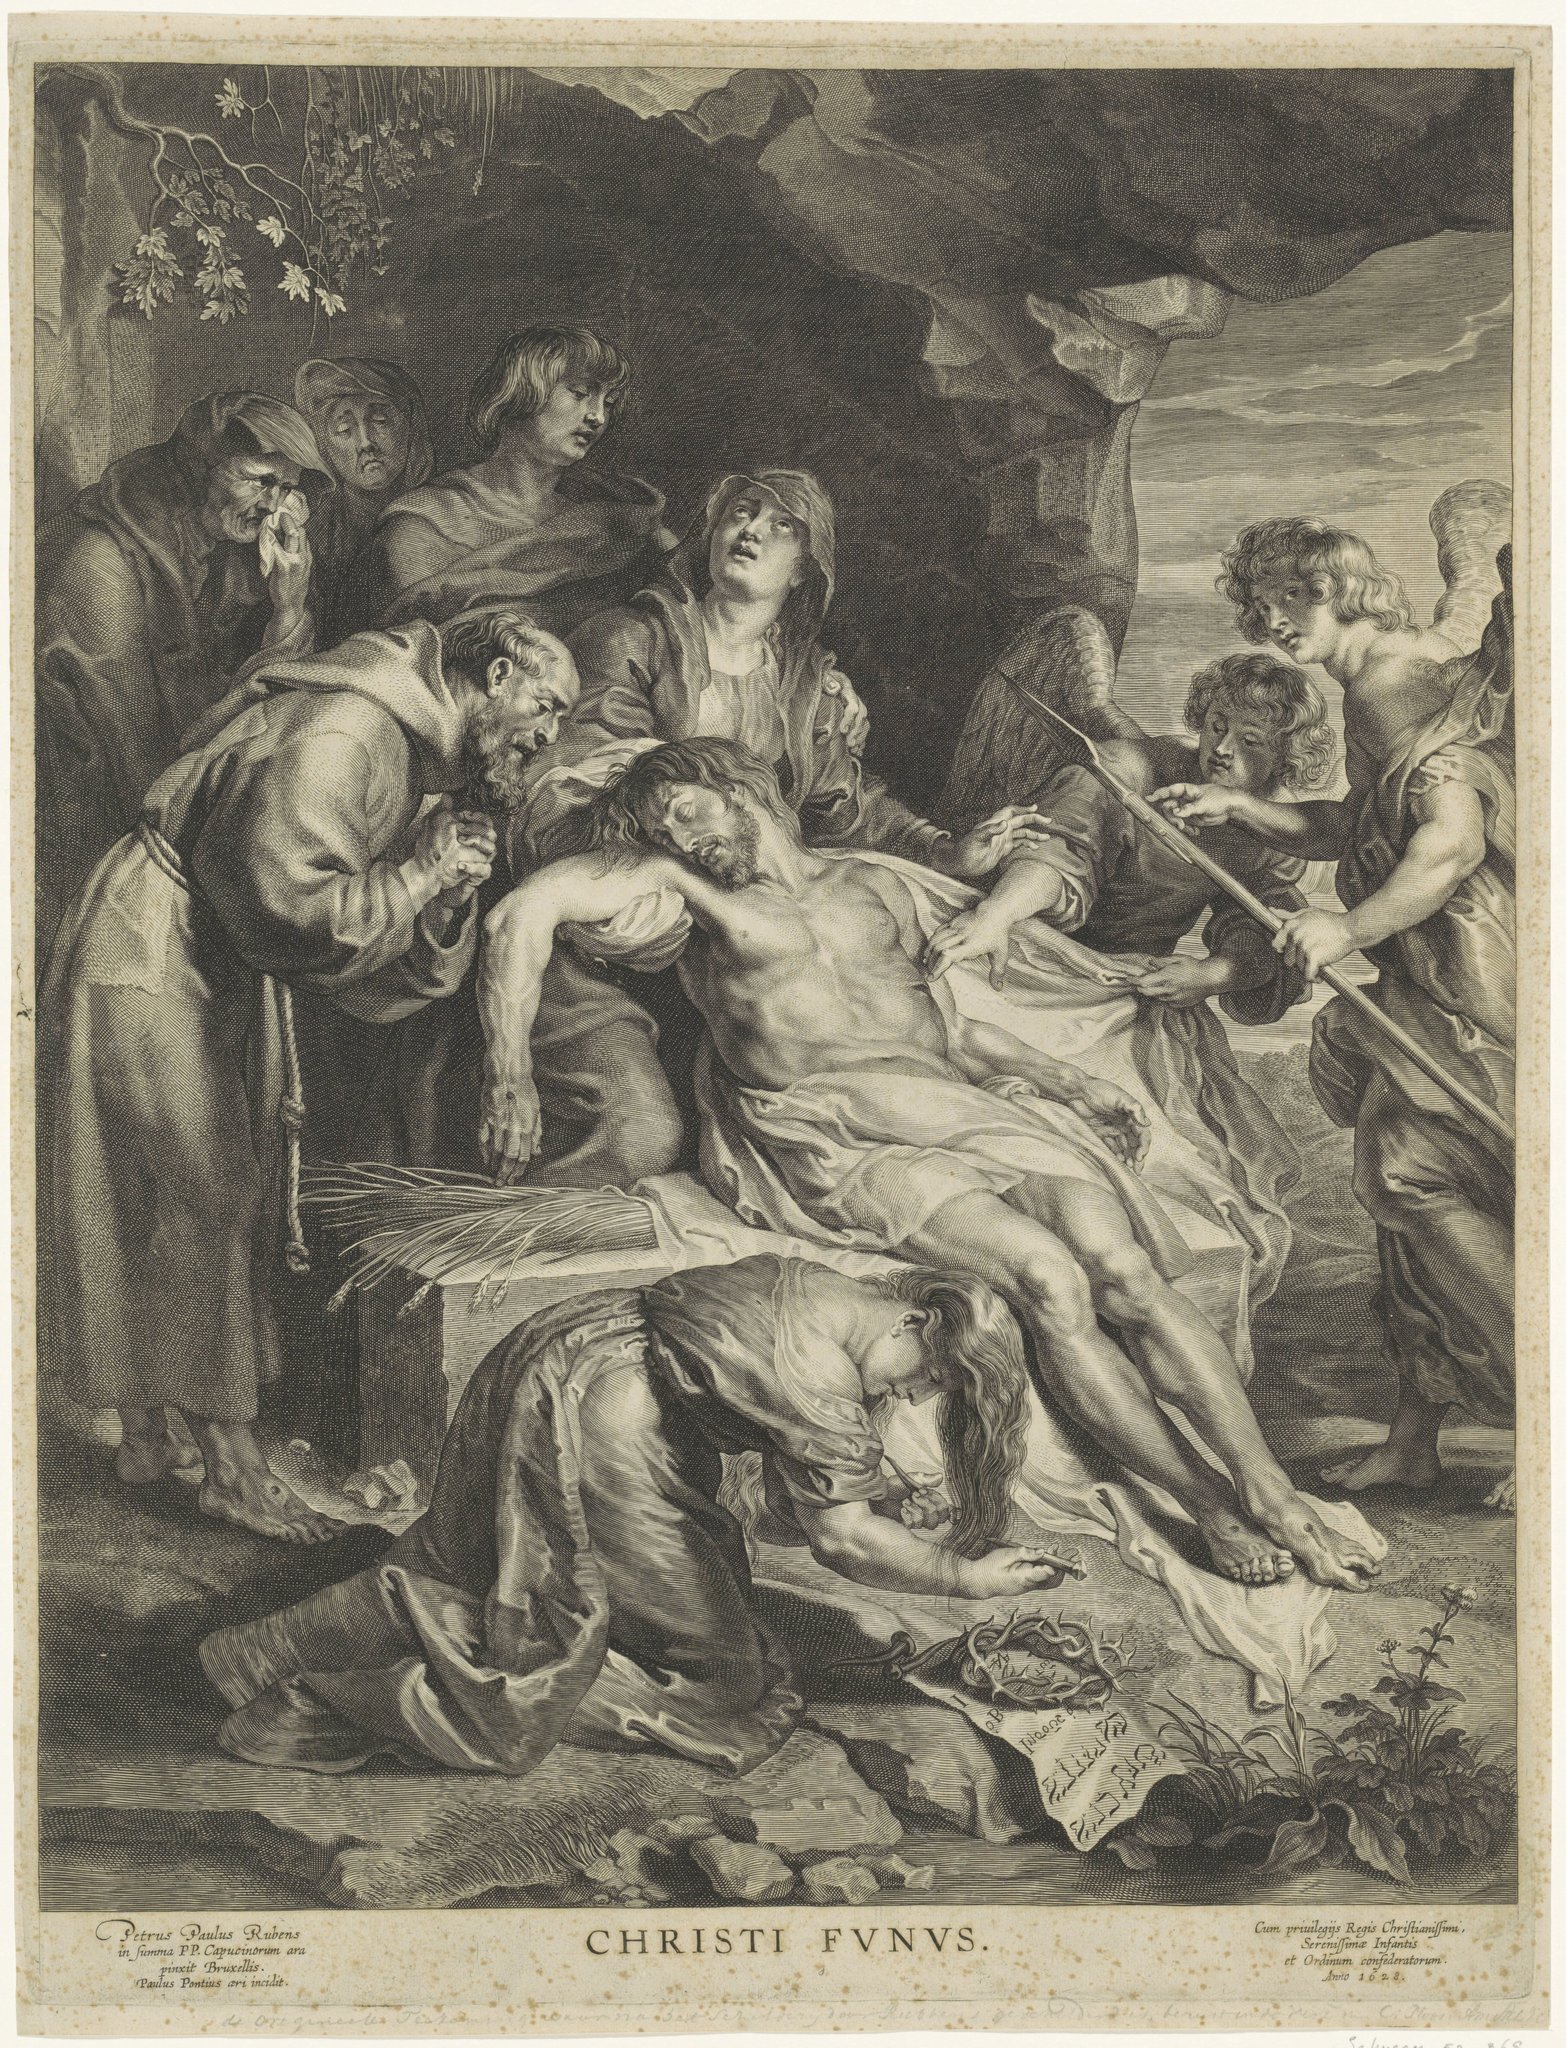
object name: print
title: Christi Funus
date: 1628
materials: paper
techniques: engraving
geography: brussels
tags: lamentation over the dead christ by his relatives and friends (christ usually without crown of thorns)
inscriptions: collector's mark: Lugt 11, collector's mark: Lugt 10, inscription: ‘de origineele Teekening waar na [d]at schilderij door Rubbbenzis geschilderd is, berust inde verz. van C: Ploos v Amstel’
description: Christus wordt in zijn graf gelegd. Achter hem staan Maria, Franciscus van Assisi en Johannes de Doper. Aan zijn voeten knielt Maria Magdalena. Rechts twee engelen, van wie één wijst op de wond in de zij van Christus.